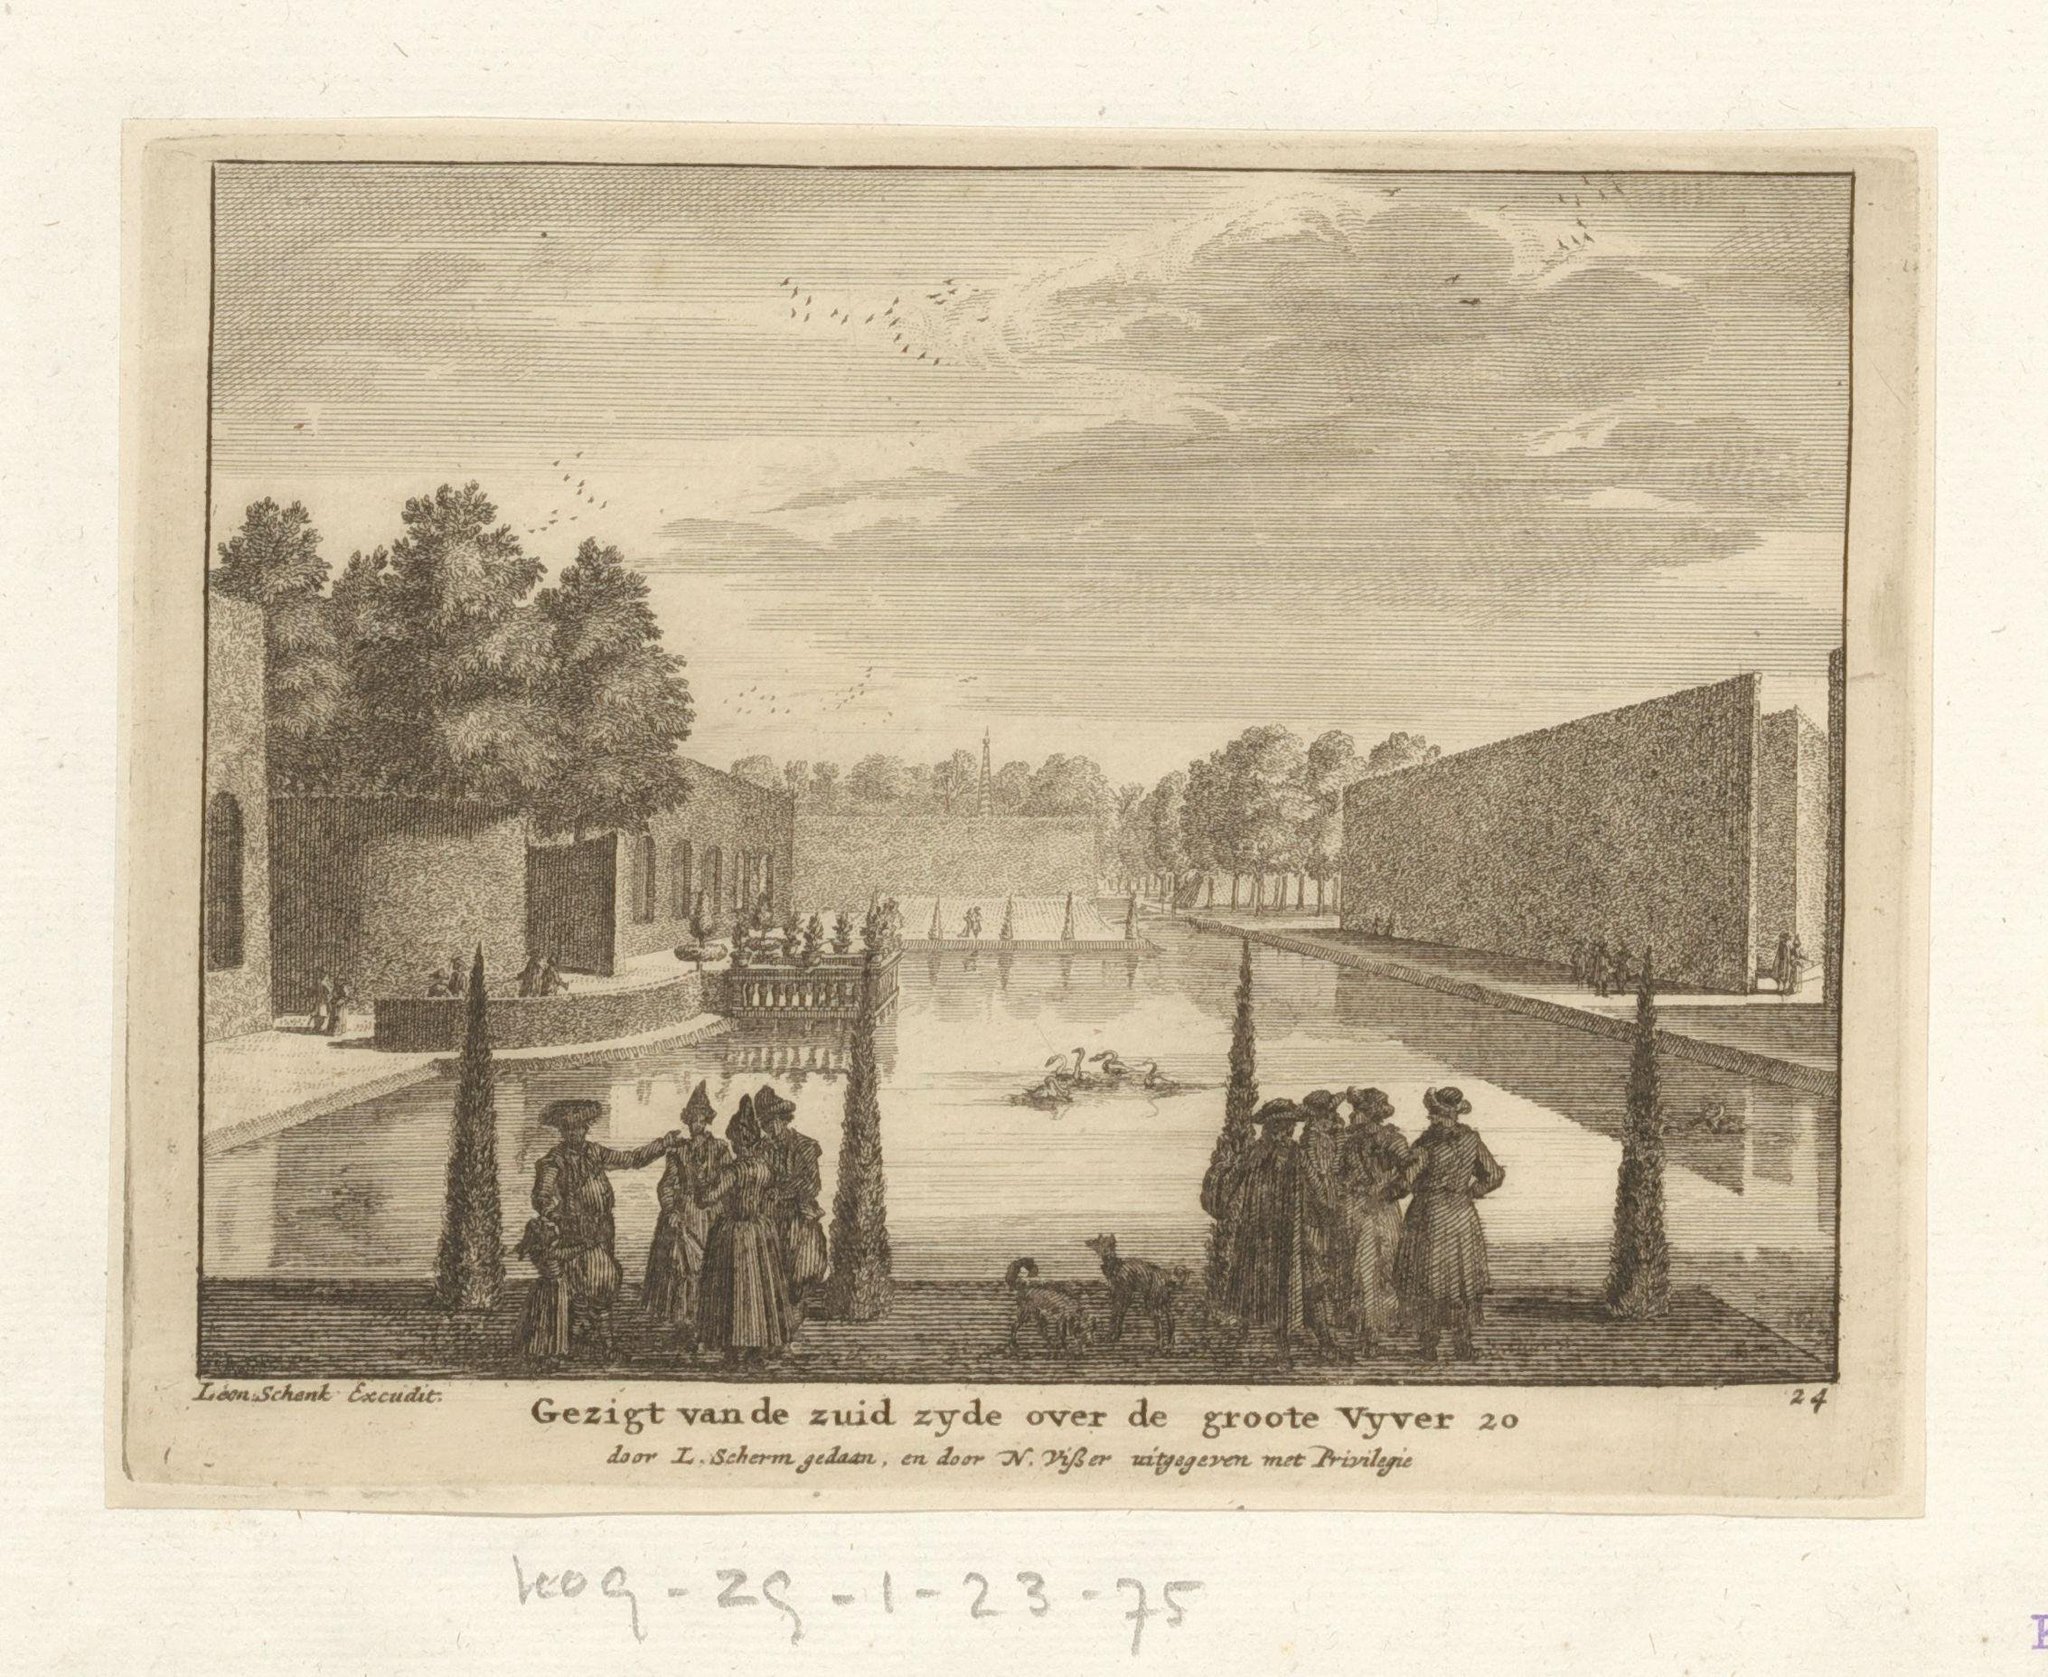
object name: print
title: Gezigt van de zuid zyde over de groote Vyver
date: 1706-1767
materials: paper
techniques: engraving, etching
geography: amsterdam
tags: french or architectonic garden; formal garden, garden pond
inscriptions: collector's mark: Lugt 1641, stamp, stamp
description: Gezicht op de grote vijver, vanaf de zuidzijde, op landgoed Clingendael te Den Haag. Op de voorgrond een elegant gezelschap. In de vijver zwemmen zwanen. Onderwerpsrubrieken binnen de Atlas Zeden en Gewoonten: Zeden en Gewoonten in Engeren Zin, De Woning. Kastelen en buitenplaatsen. Holland.